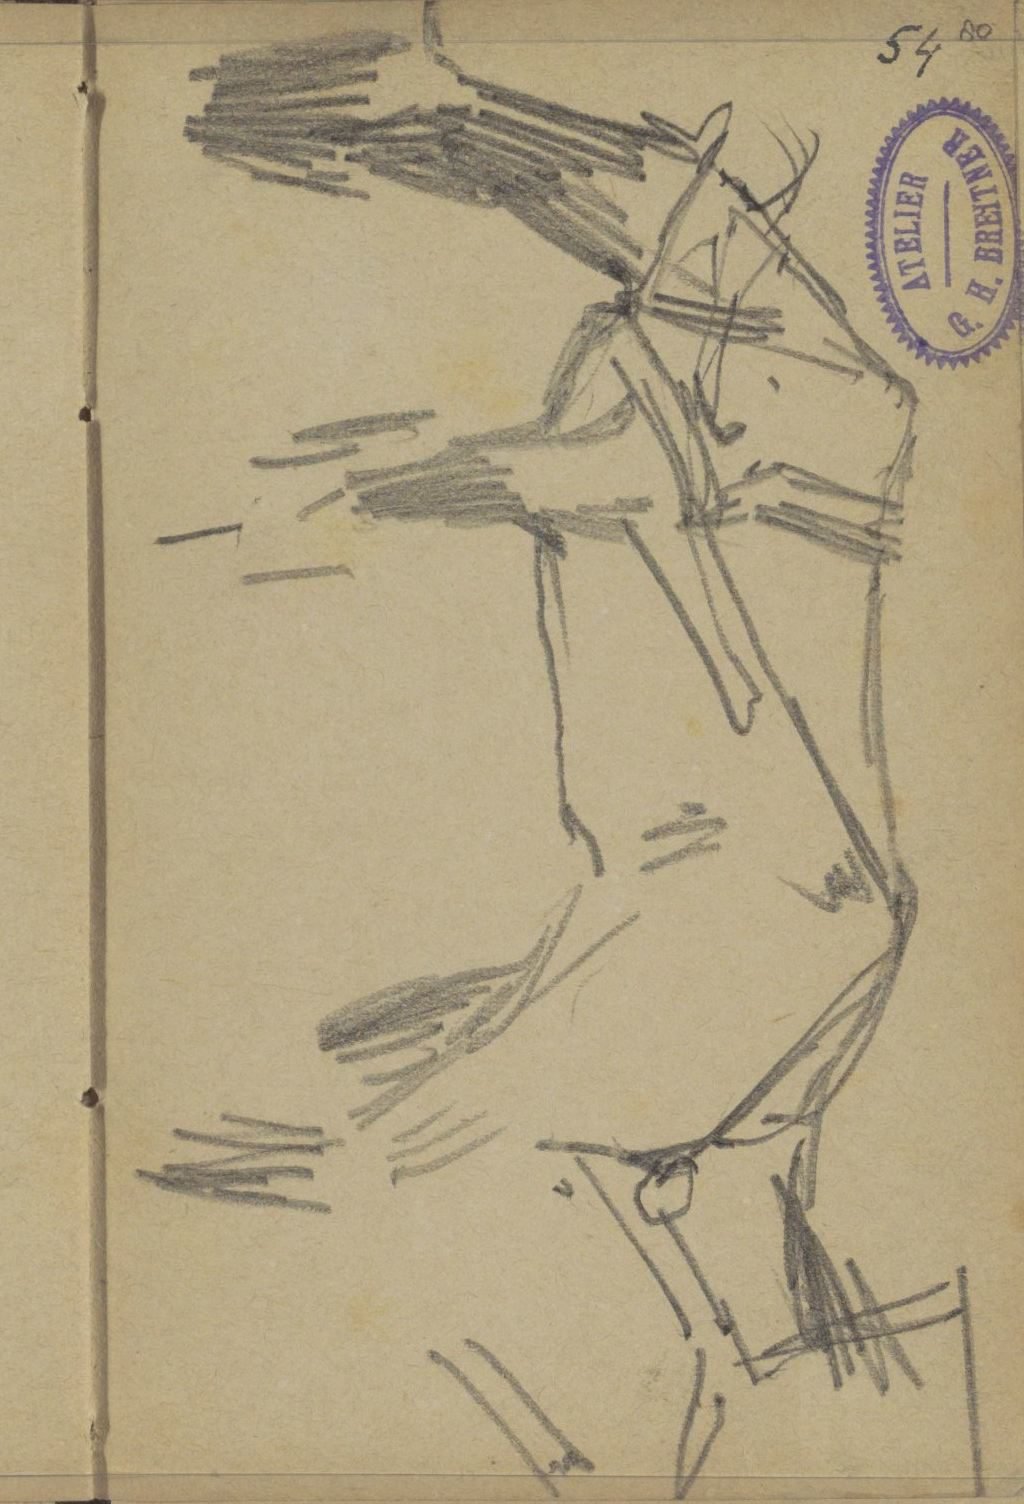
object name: sketchbook leaf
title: Aangespannen paard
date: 1887-1891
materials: paper, pencil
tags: animal traction, animal-drawn vehicle (carriage etc.), horse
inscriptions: workshop stamp: Lugt 291d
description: Pagina 80 uit een schetsboek met 83 bladen.